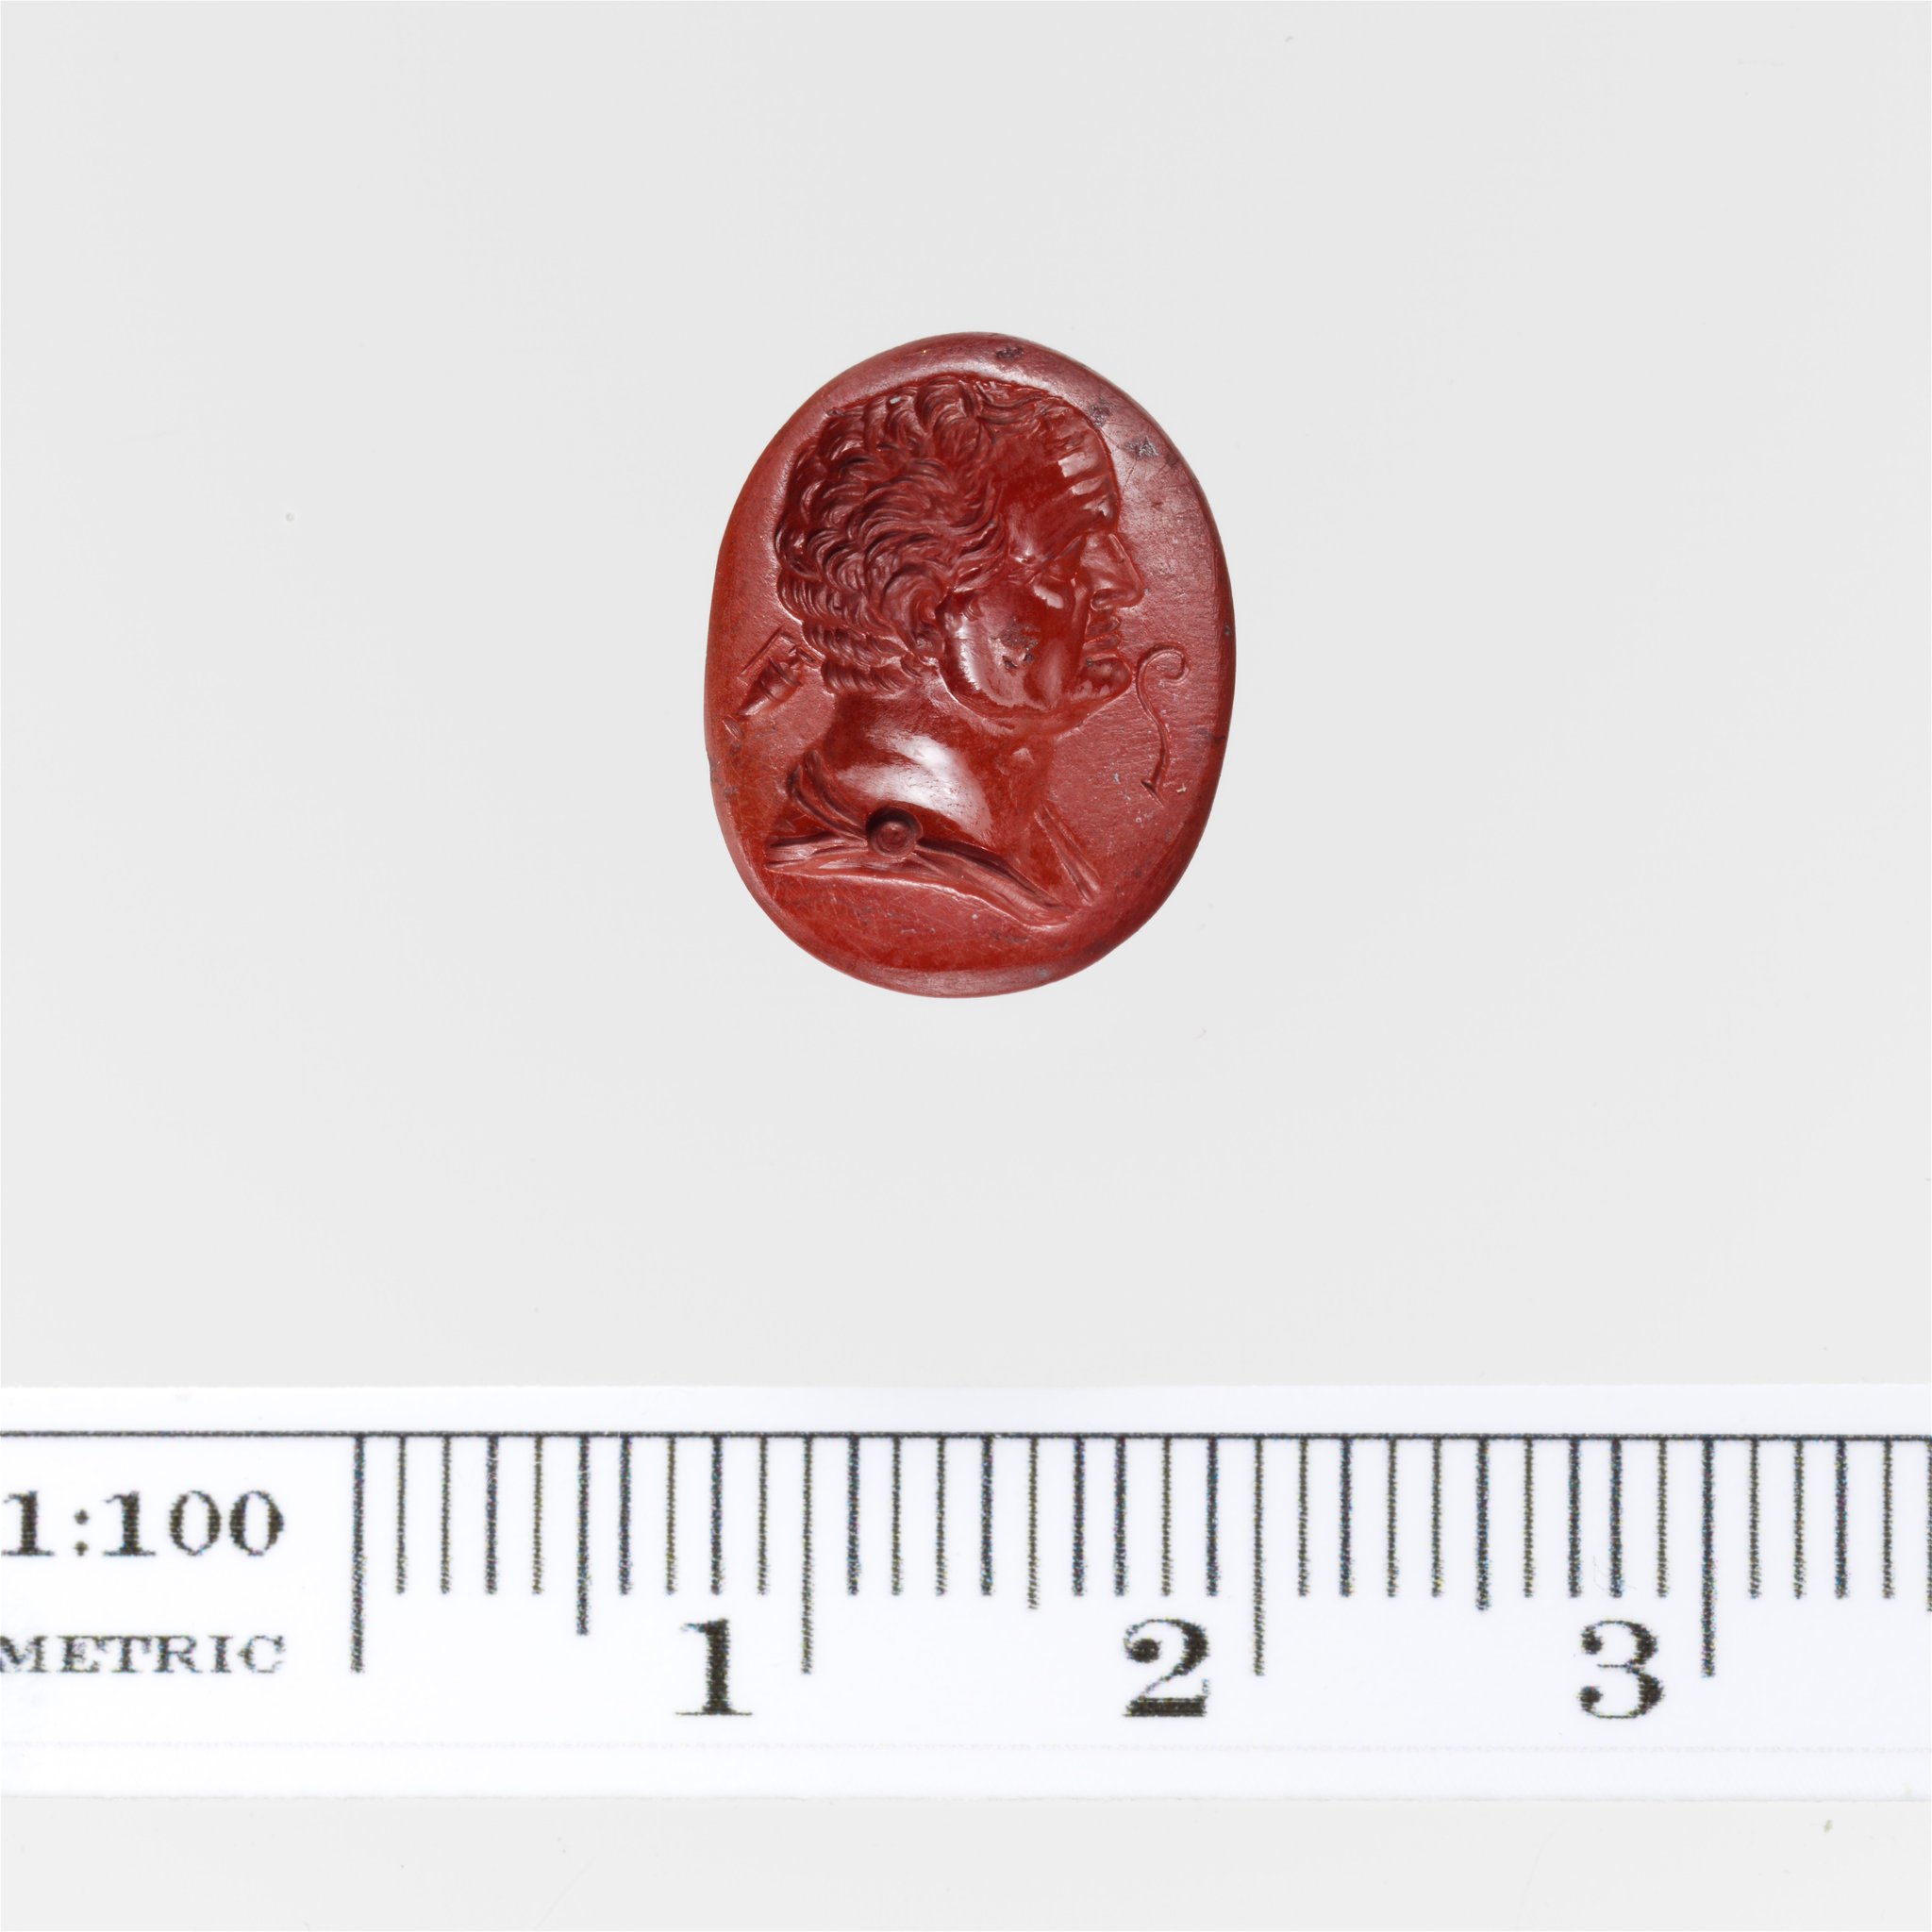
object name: intaglio, portrait of vespasian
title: Jasper ring stone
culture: roman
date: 69-79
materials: jasper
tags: kings,profiles